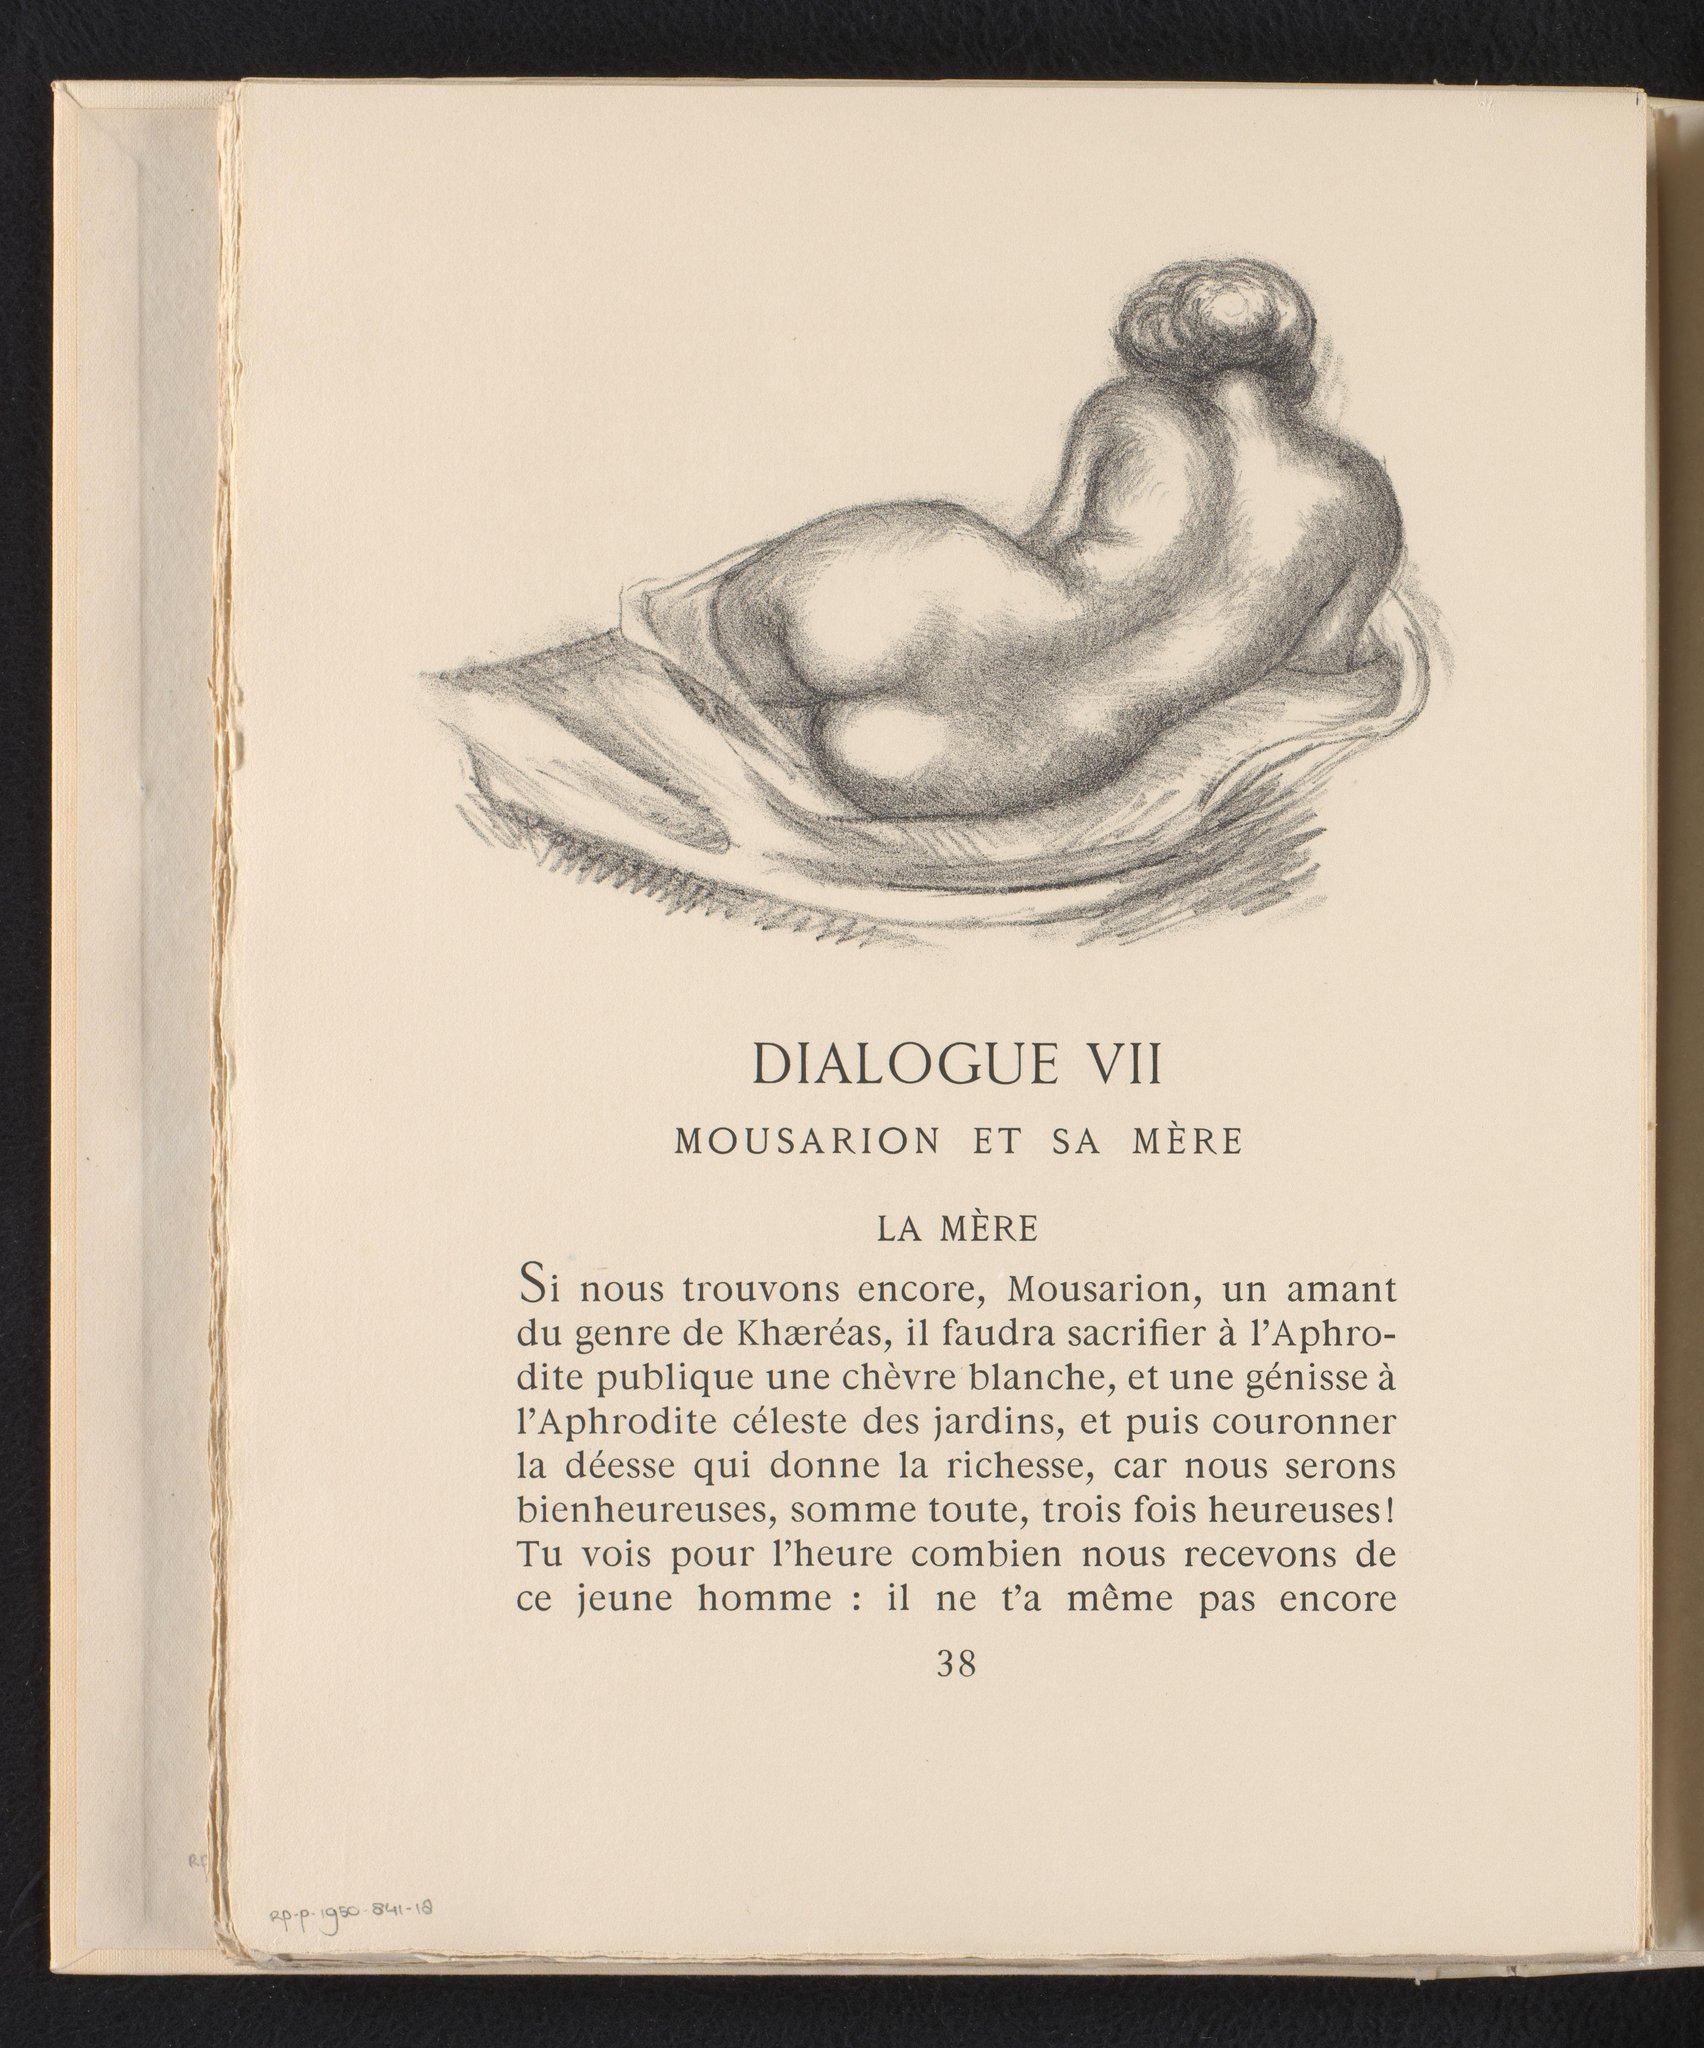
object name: print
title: Op een arm leunende liggende naakte vrouw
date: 1948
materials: paper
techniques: letterpress printing, lithograph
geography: paris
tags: lying on one side, with uplifted upper part of the body and leaning on the arm - aa - female human figure, woman (showing herself) undressed, quasi-nude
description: Prent uit: Lucianus van Samosata. Dialogues des Courtisanes. [Vertaald uit het Grieks door] Charles Astruc. Parijs: s.n., 1948, p. 38.